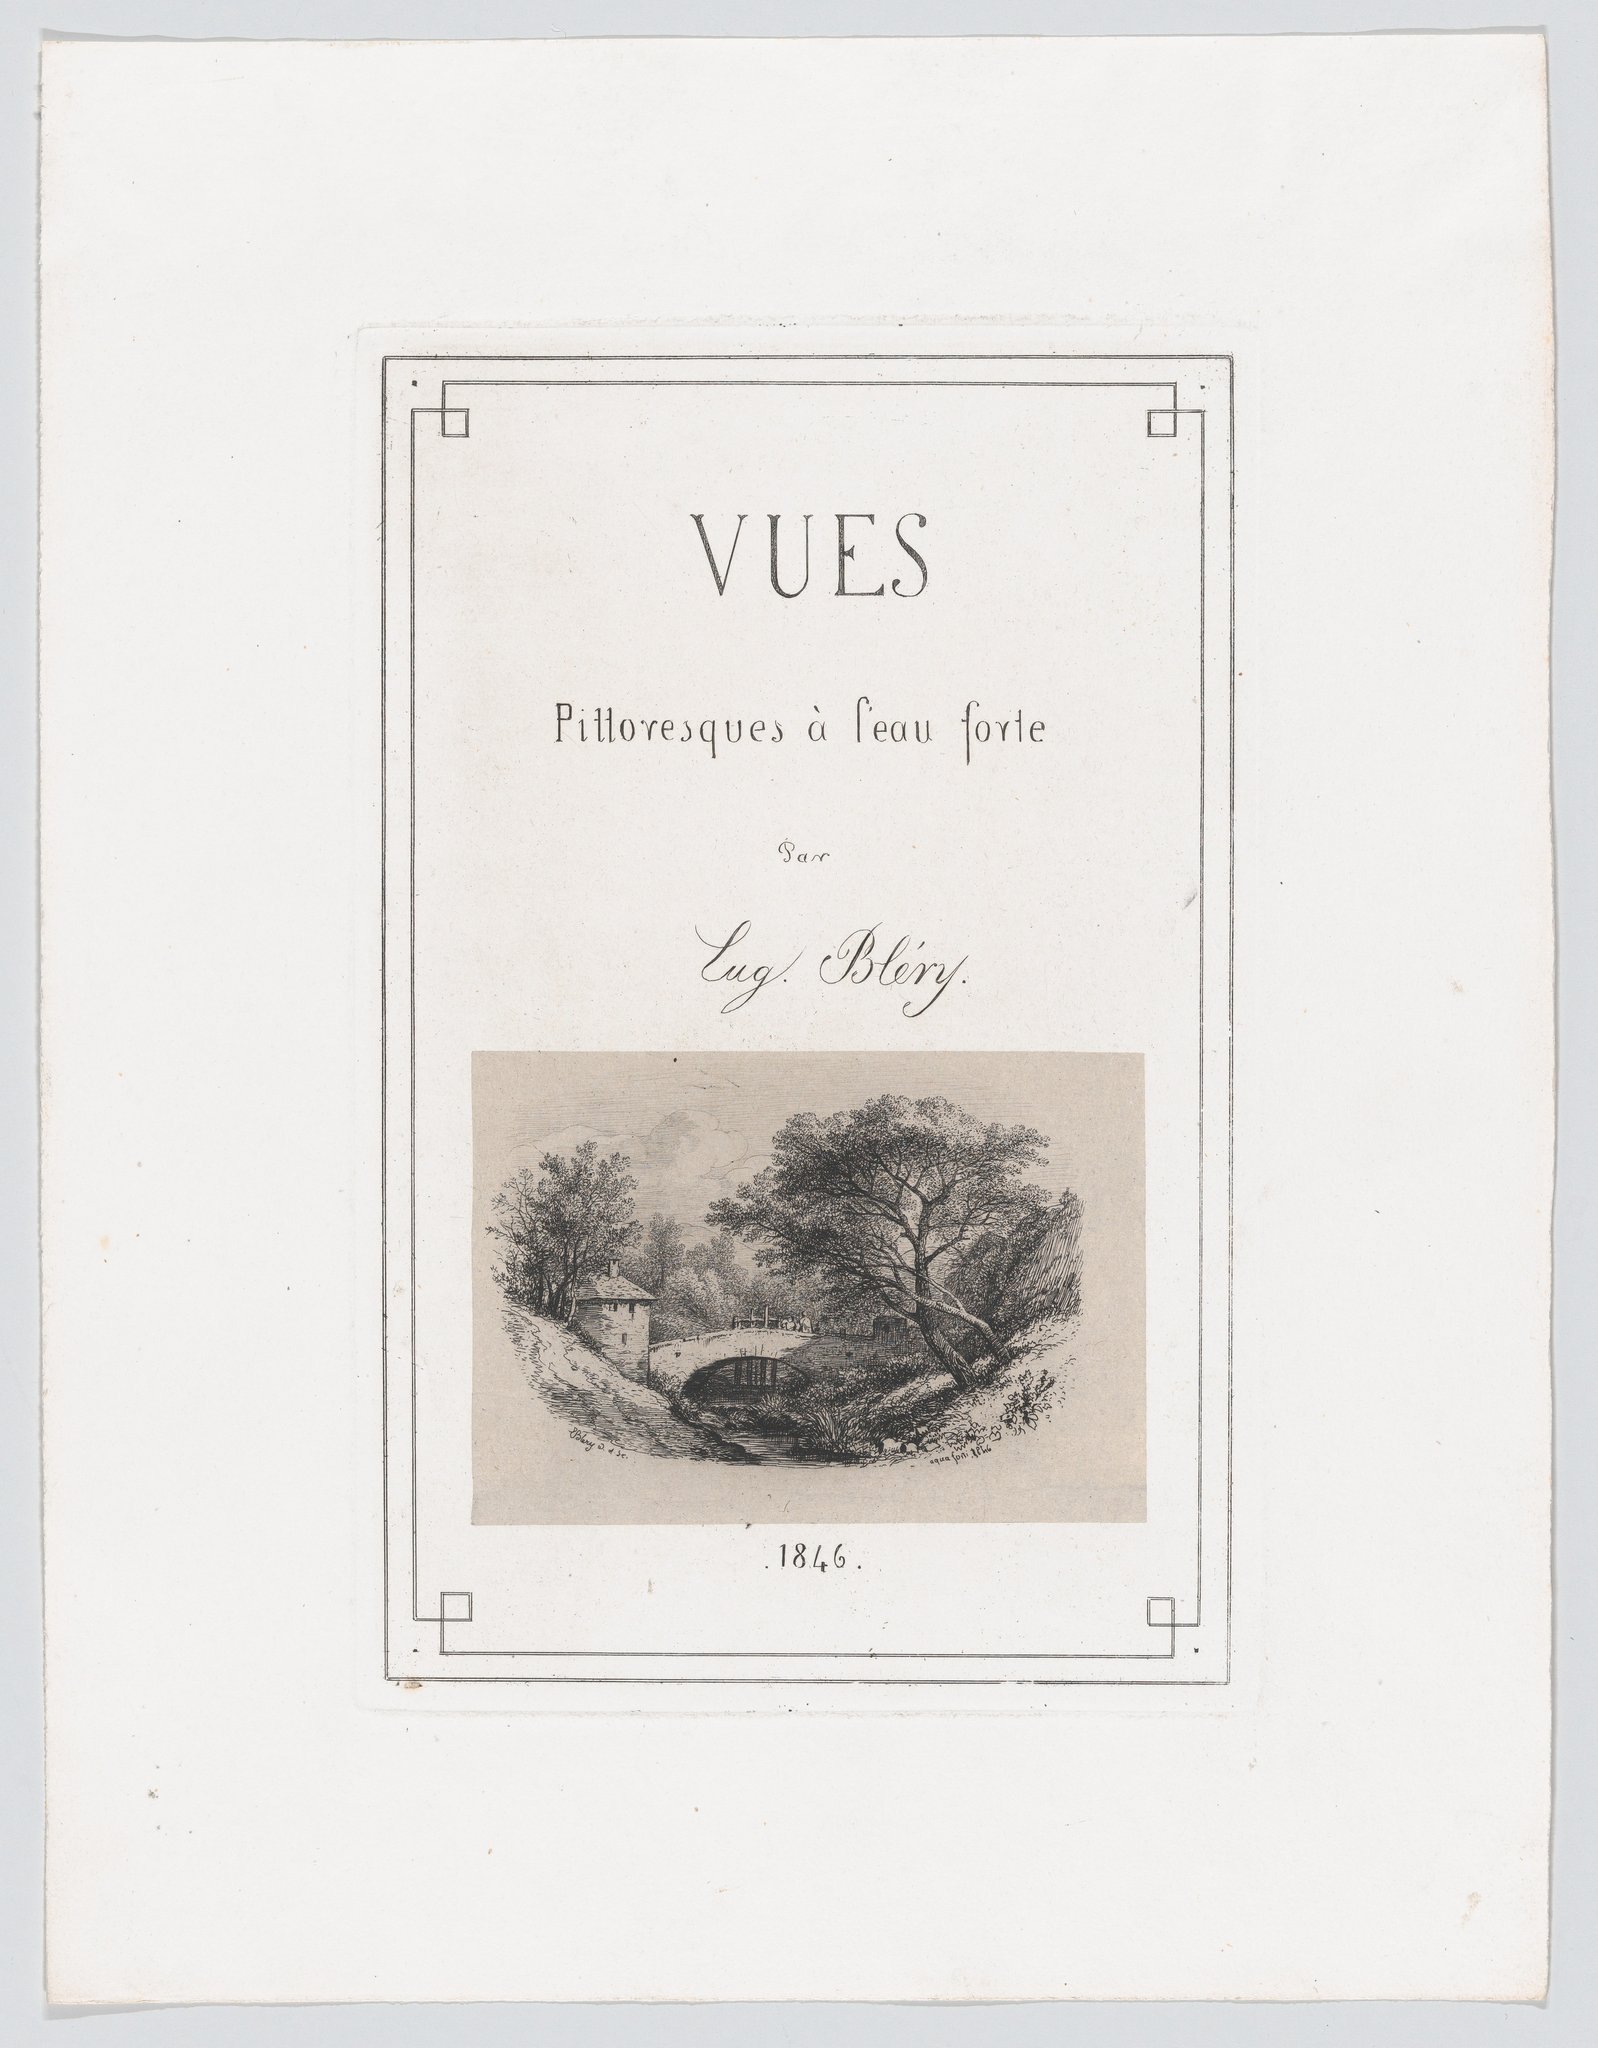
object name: print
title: Little Oval with a Pine Tree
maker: eugène bléry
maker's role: artist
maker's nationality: french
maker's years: 1805-1887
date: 1846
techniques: etching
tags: bridges,landscapes,trees